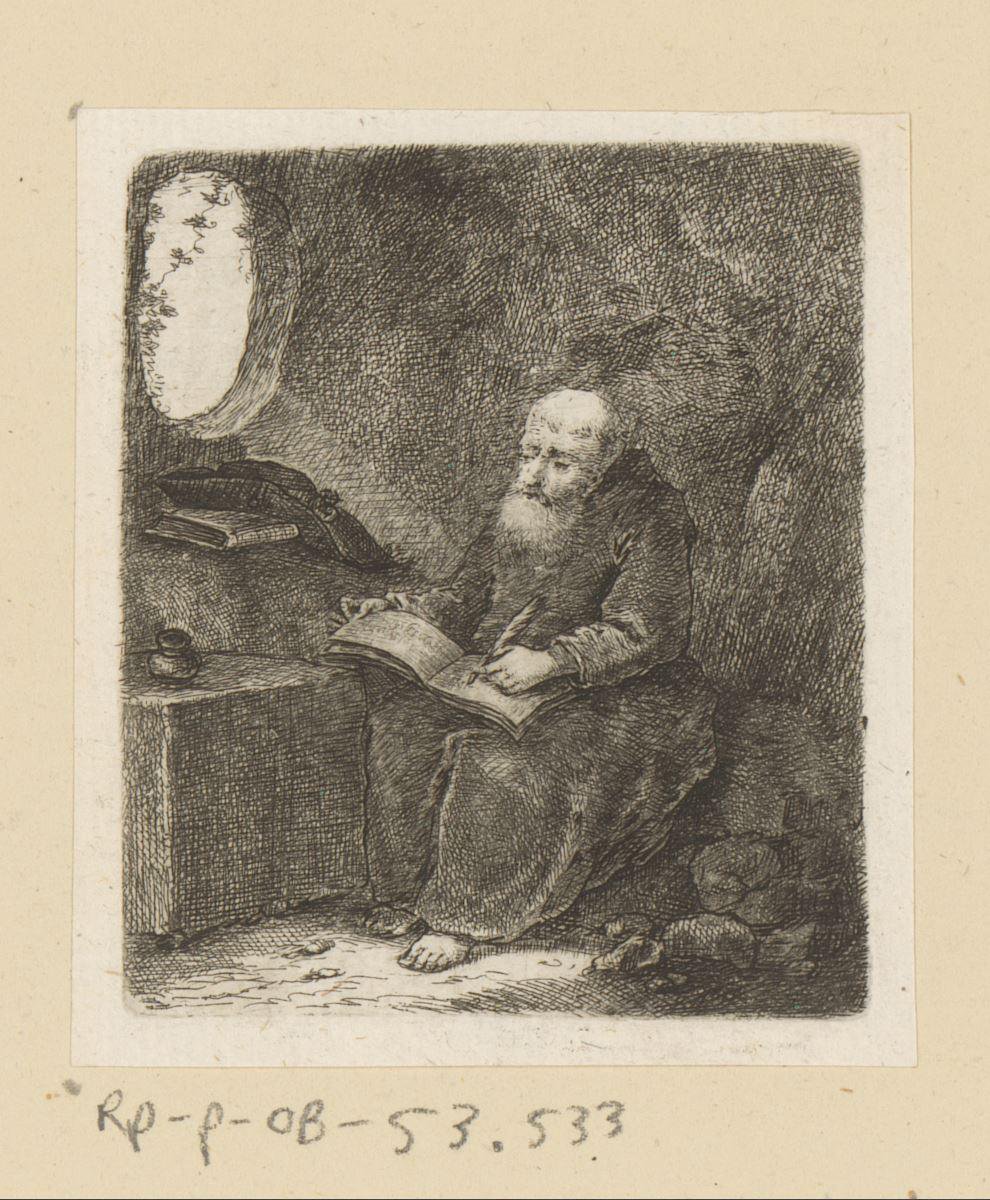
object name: print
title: Schrijvende kluizenaar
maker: johann andreas benjamin nothnagel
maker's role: print maker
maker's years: 1729-1804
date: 1739-1804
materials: paper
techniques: etching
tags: anchorite, hermit, writing accessories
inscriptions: collector's mark: Lugt 240